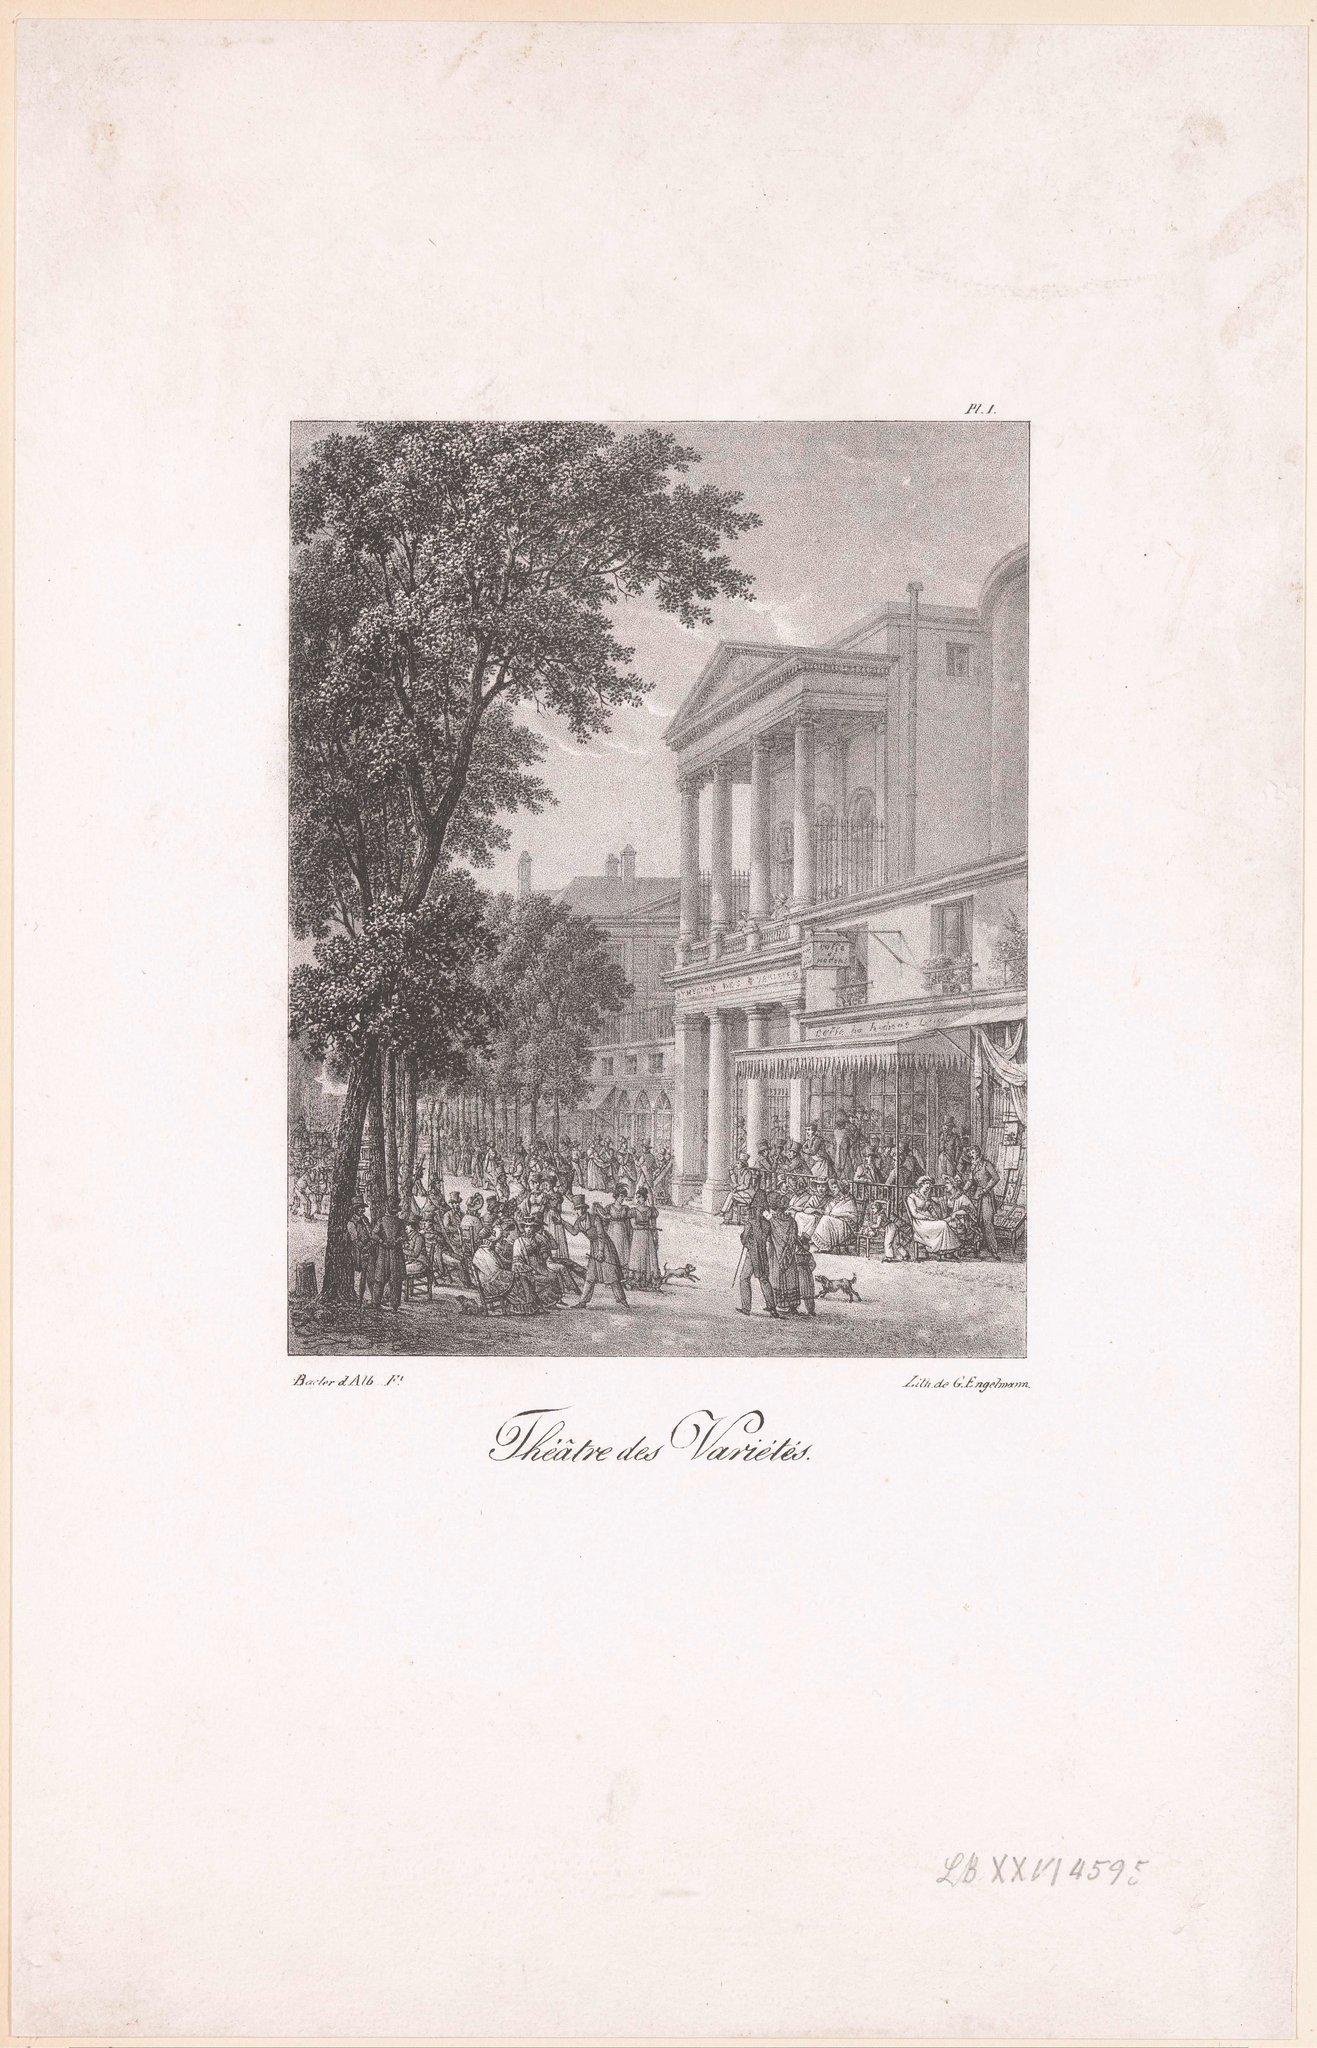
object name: print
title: Zicht op het Théâtre des Variétés in Parijs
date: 1822-1824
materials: paper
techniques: lithograph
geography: paris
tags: theatre (building)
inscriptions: annotation: ‘LB XXVI 4595’